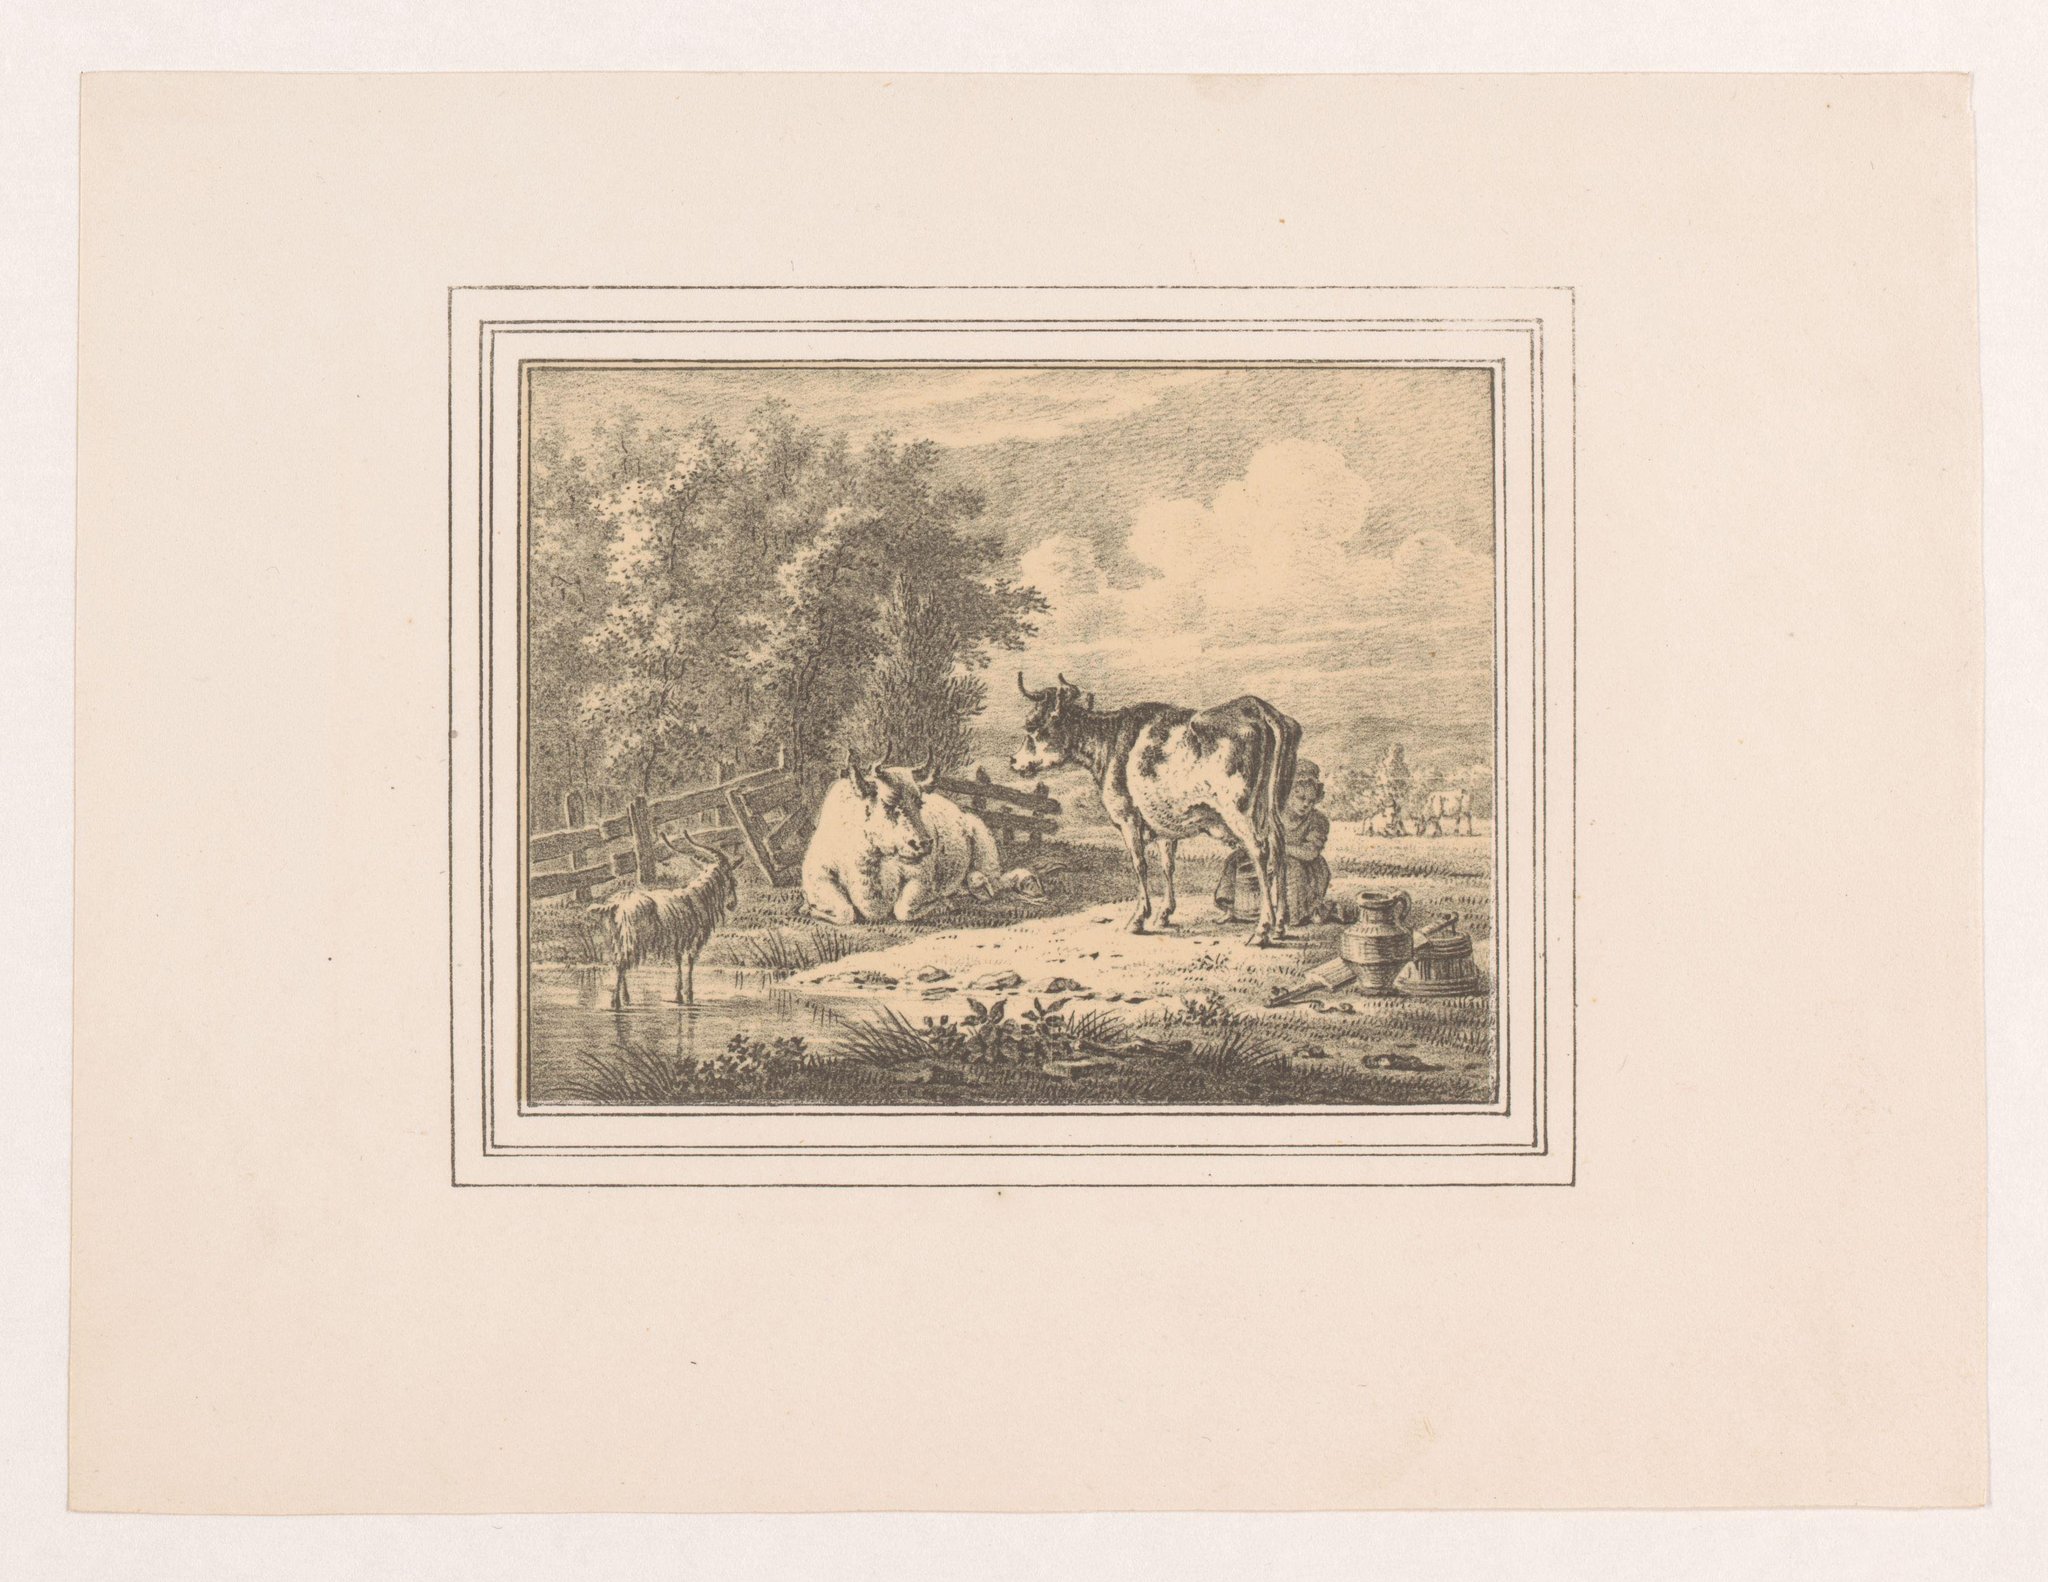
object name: print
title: Koe wordt gemolken in een landschap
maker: pieter de goeje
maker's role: draughtsman, print maker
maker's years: 1789-1859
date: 1809-1859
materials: paper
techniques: tone lithography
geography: netherlands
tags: cow, he-goat, billy-goat, meadow, pasture (+ landscape with figures, staffage), milking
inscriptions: collector's mark: Lugt 2228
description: De koe wordt gemolken door een boerin. Ernaast ligt een tweede koe voor een hek. In het water staat een geitenbok.